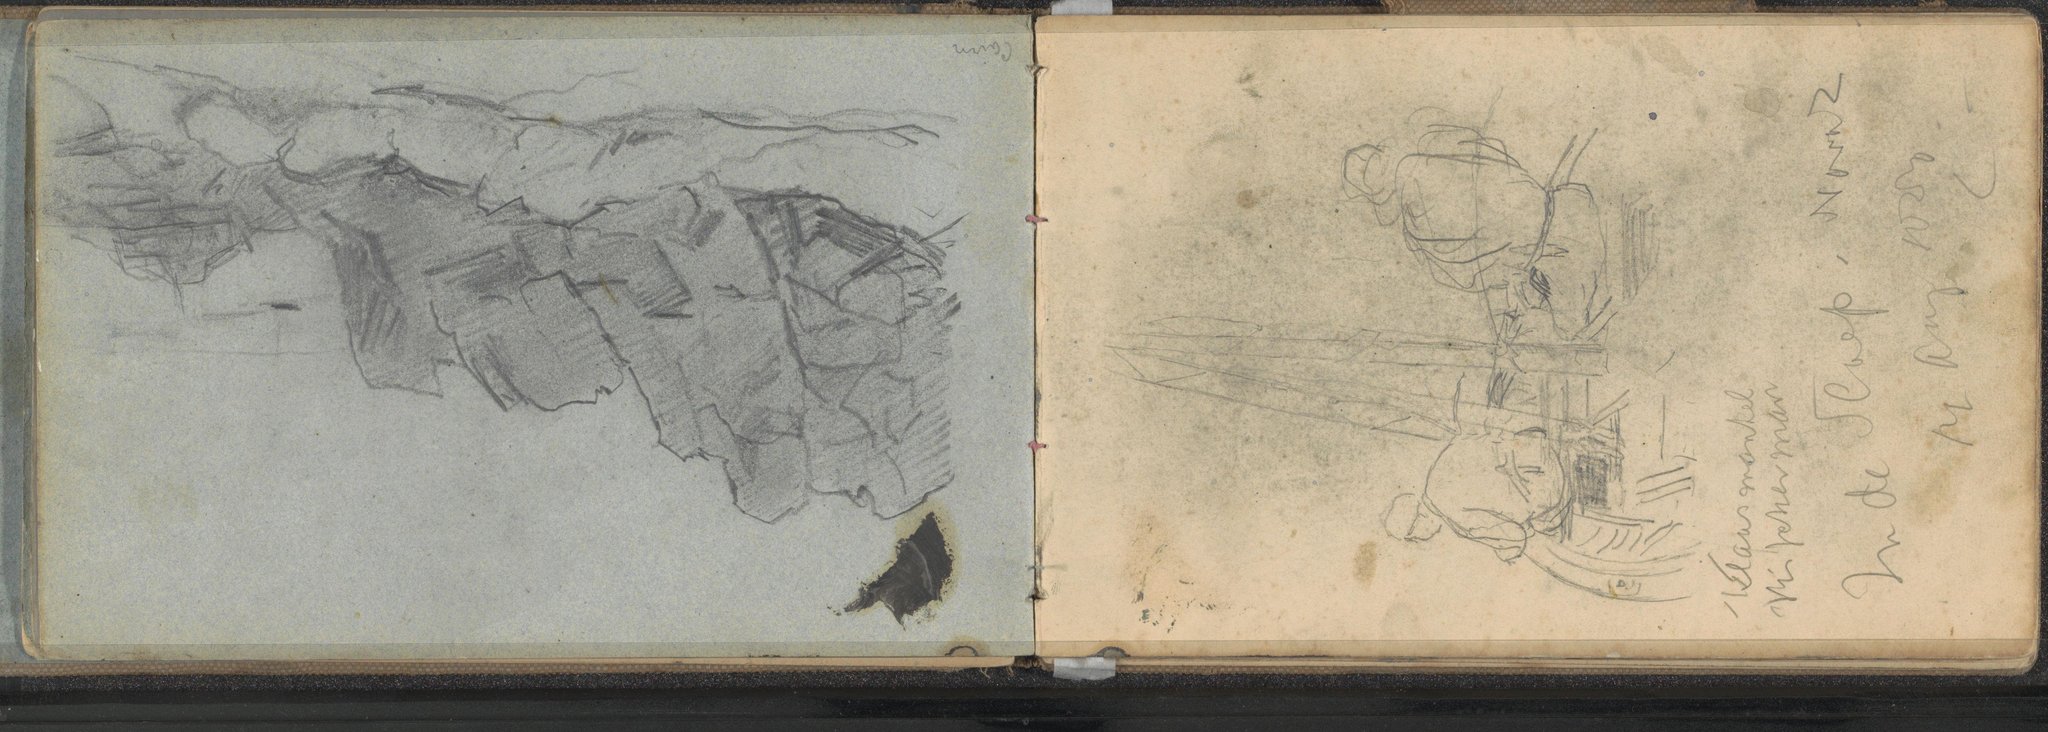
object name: sketchbook leaf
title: Twee mannen in een sloep, onder wie Klaas Mantel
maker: louis apol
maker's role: draughtsman, painter, print maker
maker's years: 1850-1936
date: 1880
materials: paper, pencil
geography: novaya zemlya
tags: adult man (+ two persons), rowing-boat, canoe, etc.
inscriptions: annotation: ‘Klaas Mantel/ Visscherman/ In de sloep, Nova Z/ 14 Aug 1880’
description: Voor de kust van Nova Zembla. Blad 15 recto uit een schetsboek met 35 bladen betekend tijdens de expeditie naar Nova Zembla in 1880.